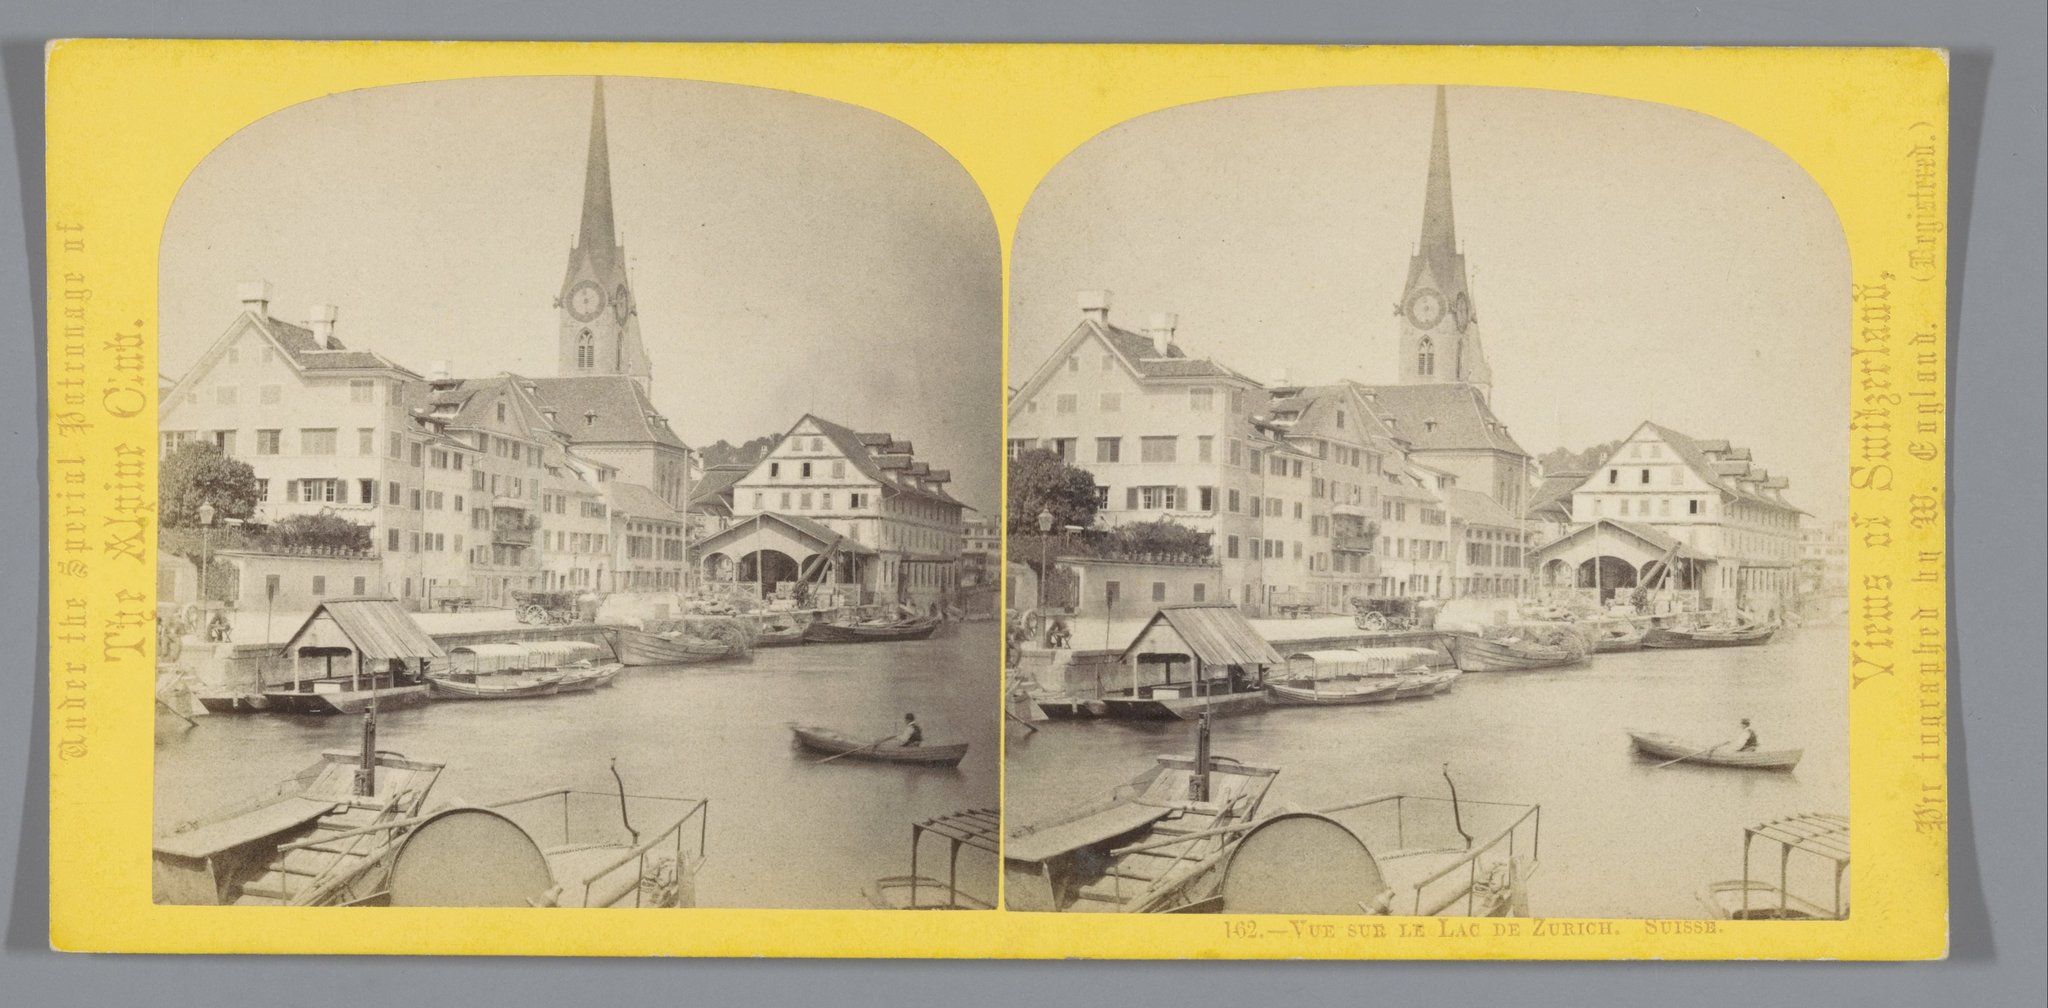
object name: stereograph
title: Gezicht op de kade van Zürich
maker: william england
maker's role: fotograaf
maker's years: 1816-1896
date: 1850-1880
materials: cardboard, photographic support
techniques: albumen print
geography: zurich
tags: church (exterior), quay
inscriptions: number: ‘162.’, inscription: ‘Views of Switzerland, photographed by W. England. (Registered) Under the Special Patronage of the Alpine Club.’